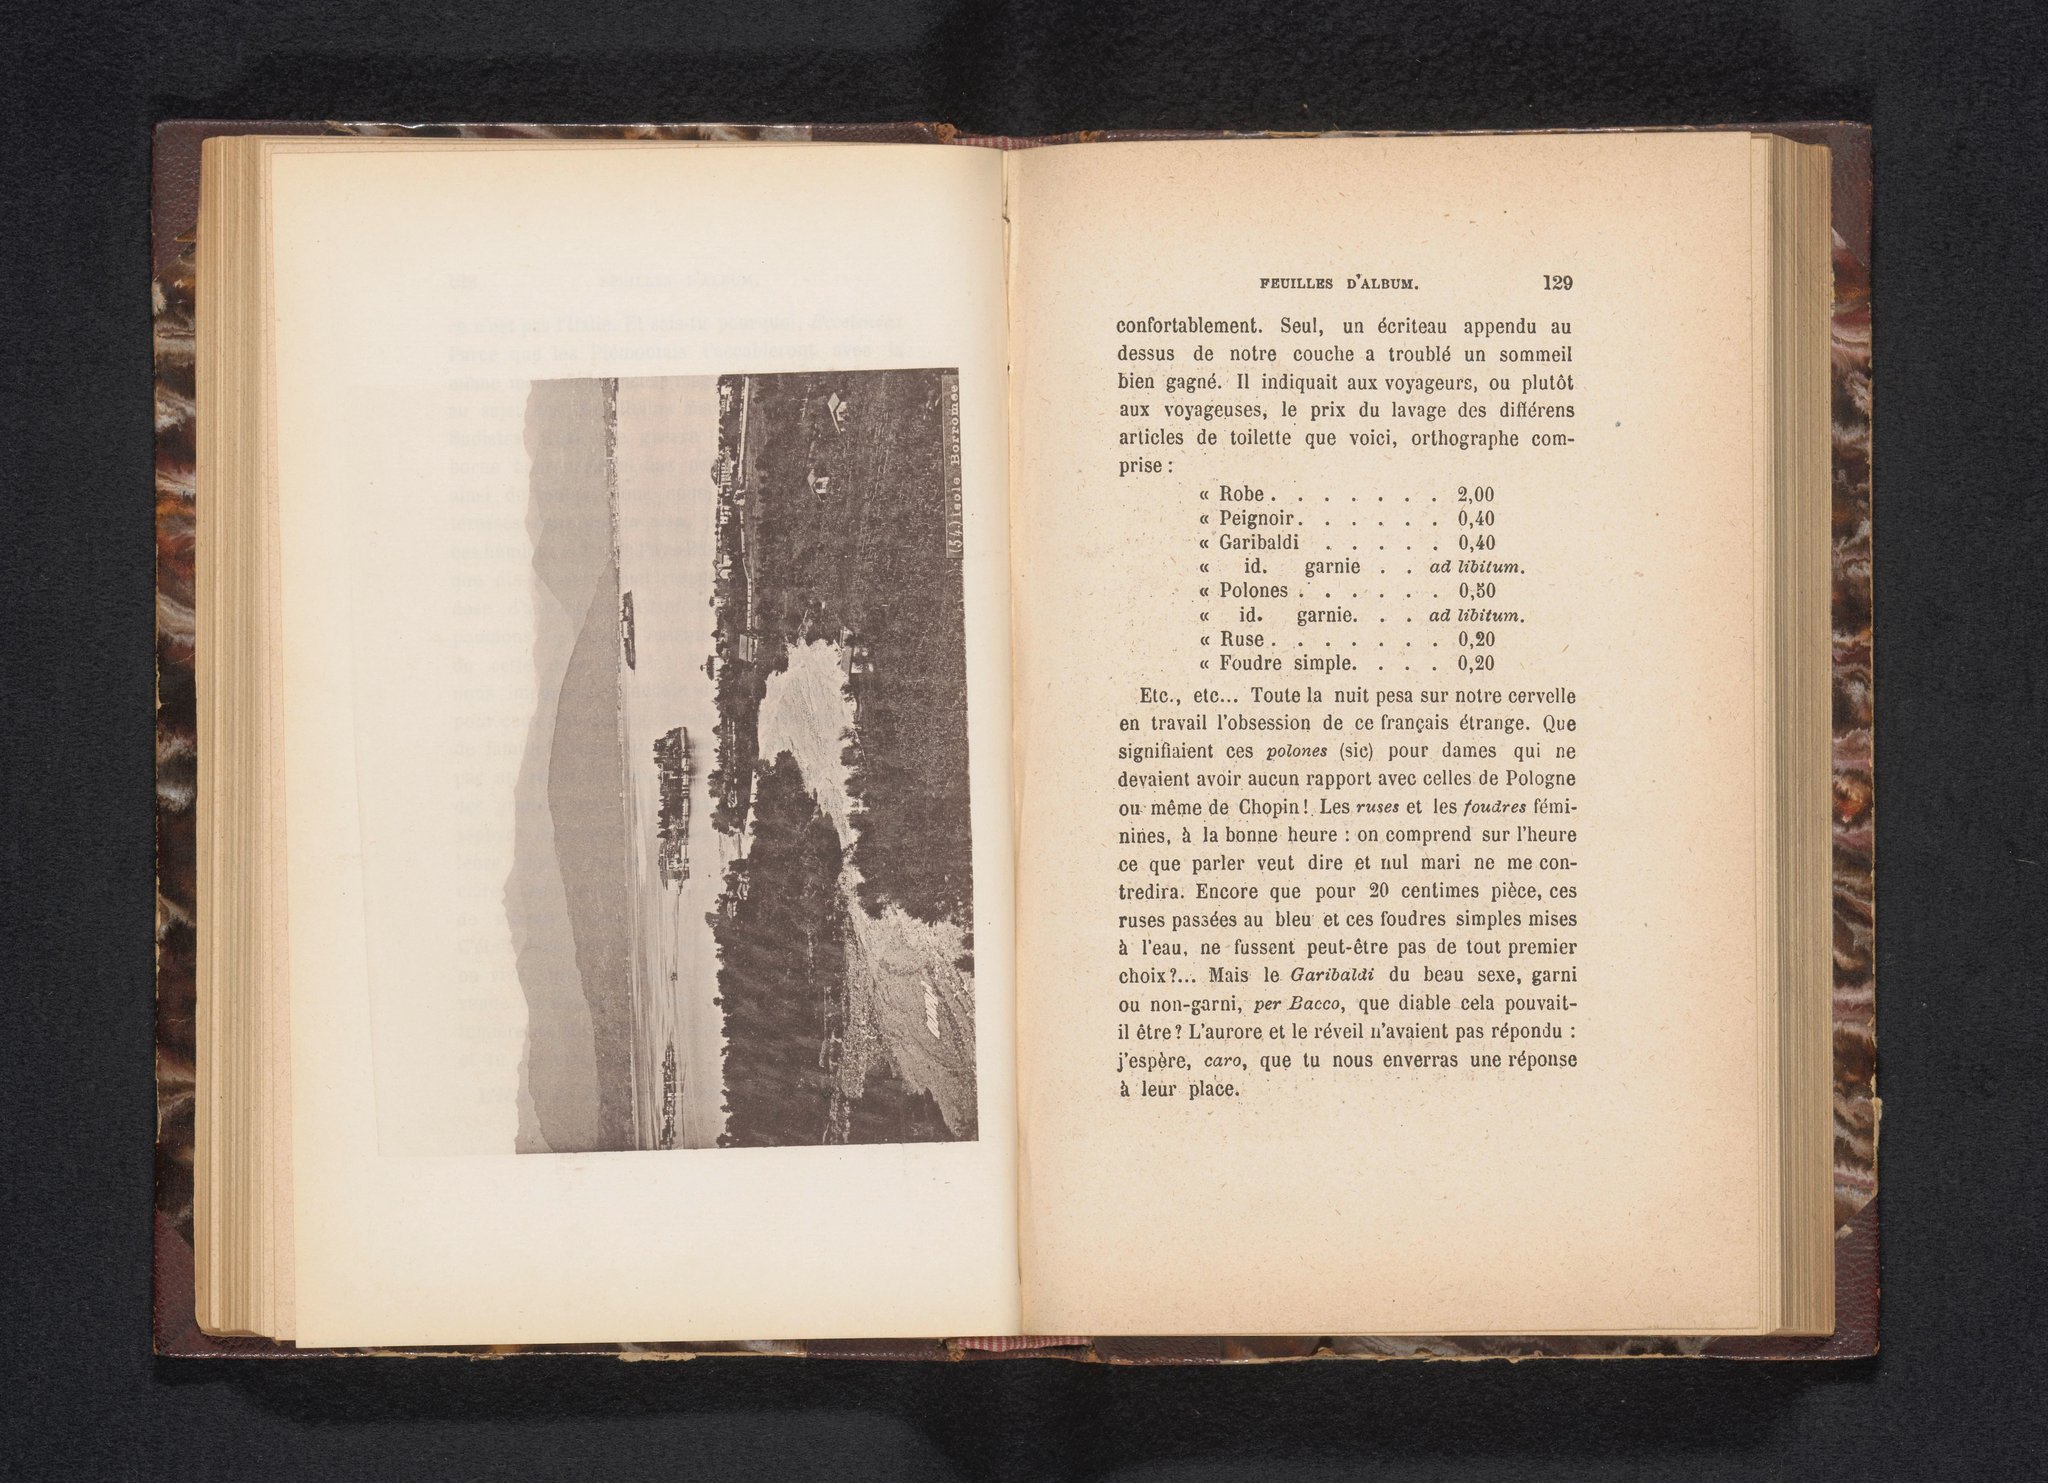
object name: page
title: Isole Borromeo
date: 1884-1889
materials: paper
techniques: photograph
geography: stresa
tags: island, lake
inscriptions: inscription: ‘(54.) isole Borromeo’